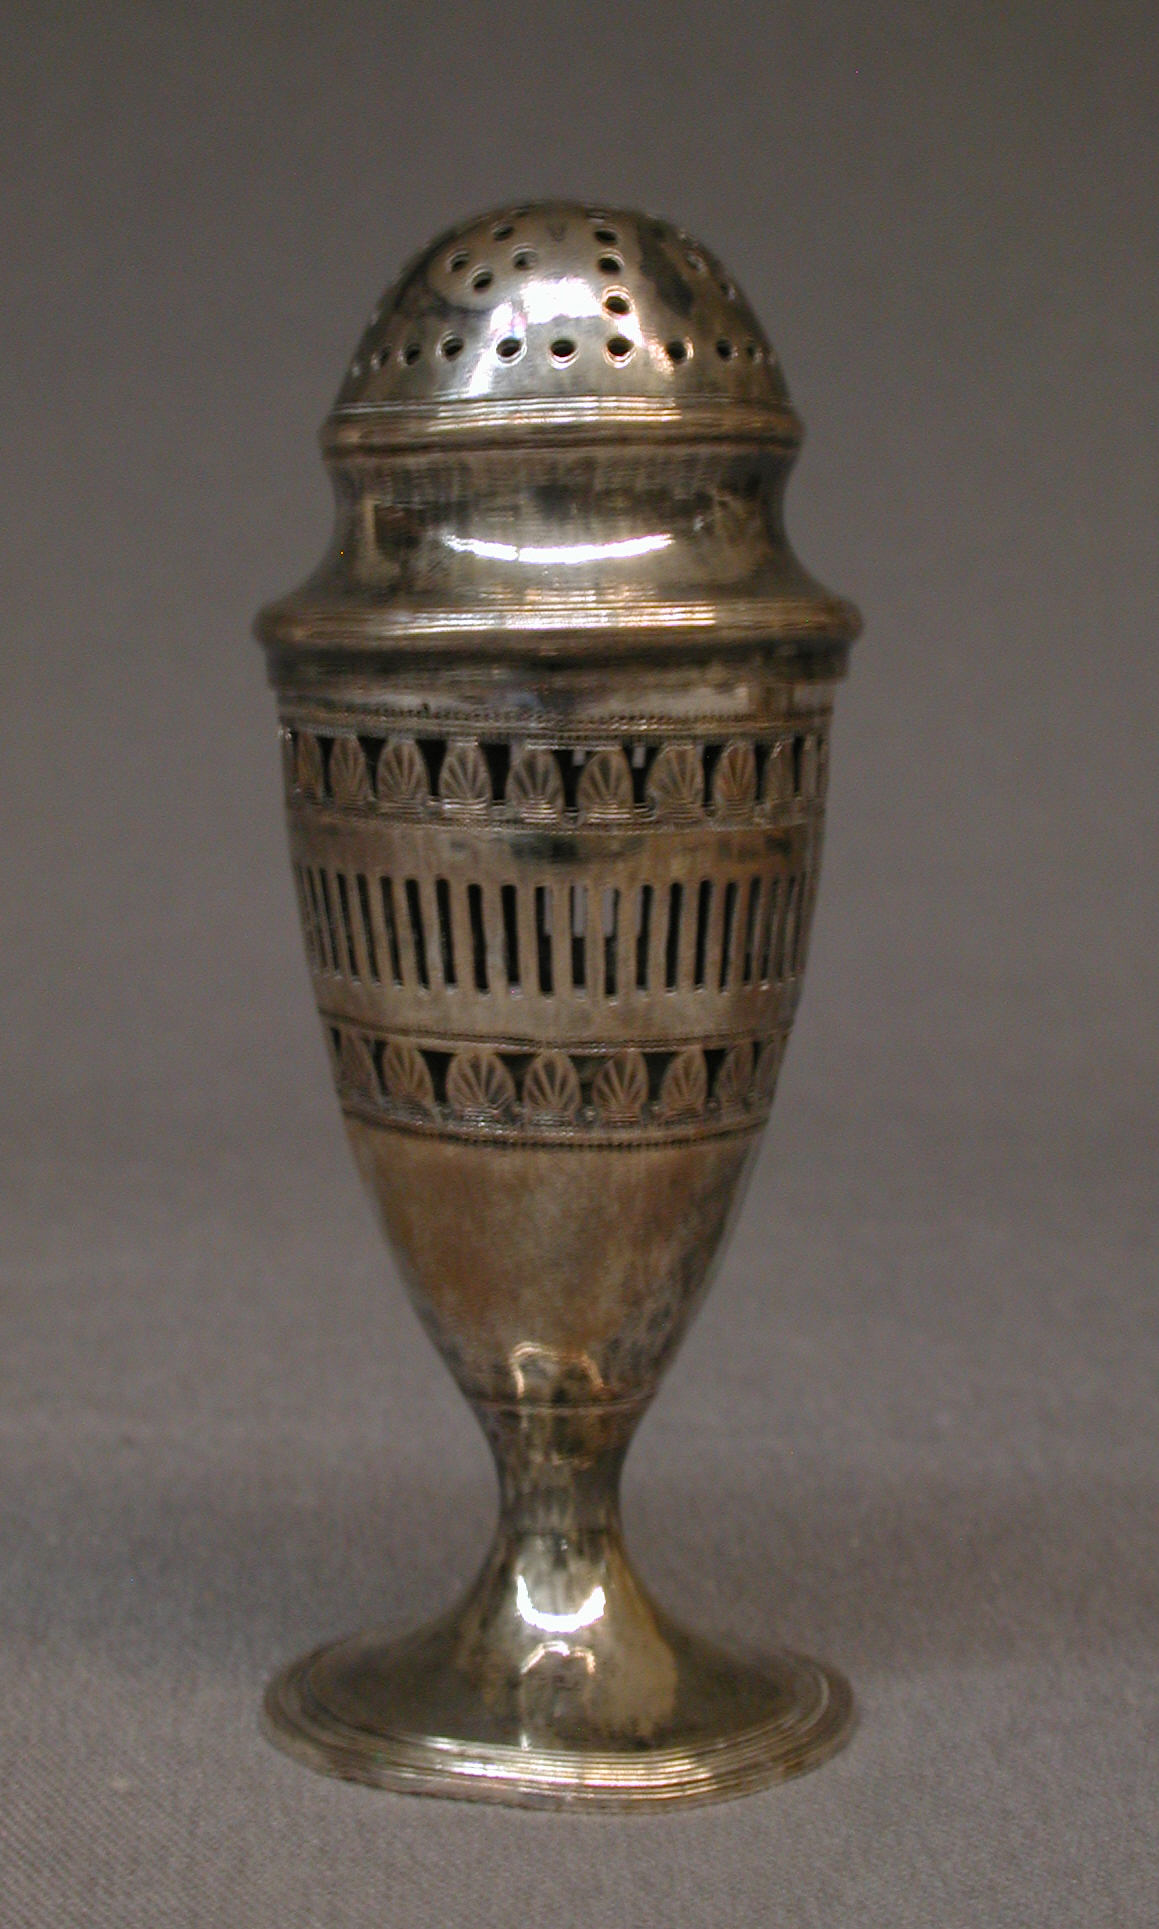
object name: caster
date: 1785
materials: metal